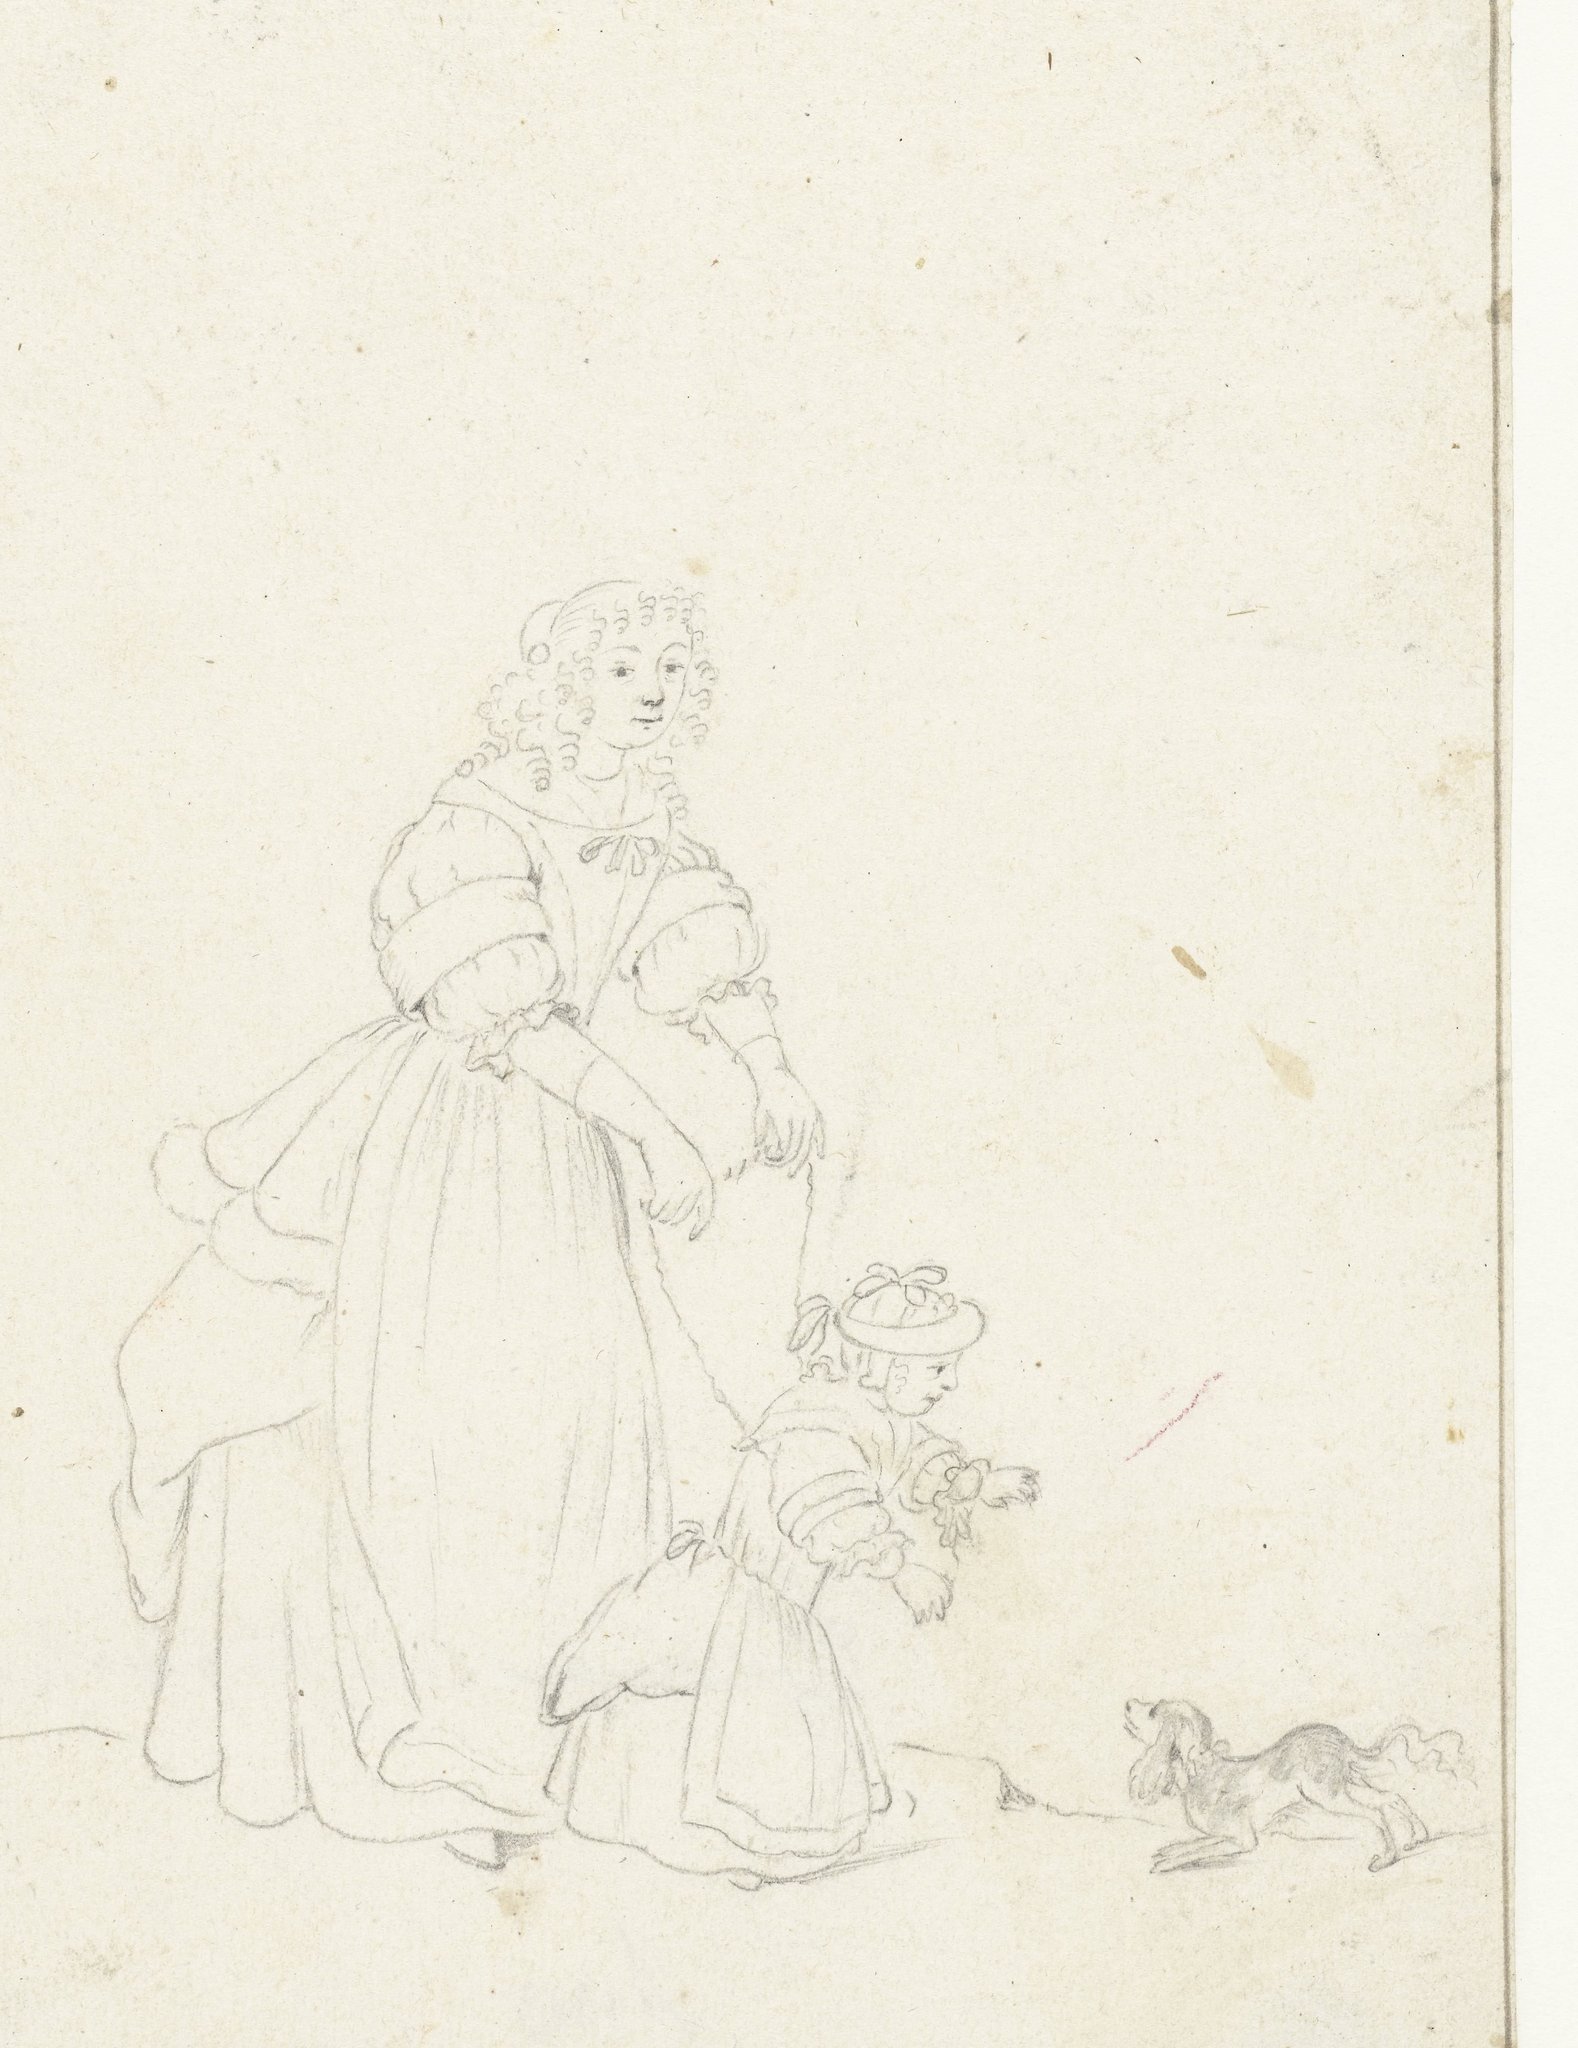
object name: drawing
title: Vrouw lopend met een kind aan leidsels en een hond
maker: gesina ter borch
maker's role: draughtsman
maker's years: 1633-1690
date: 1660-1661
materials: ink, paper, pencil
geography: zwolle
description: Een vrouw leert een kind lopen. Het kind draagt een valhoedje, een gevoerd hoofddeksel dat hem moest beschermen als hij viel.